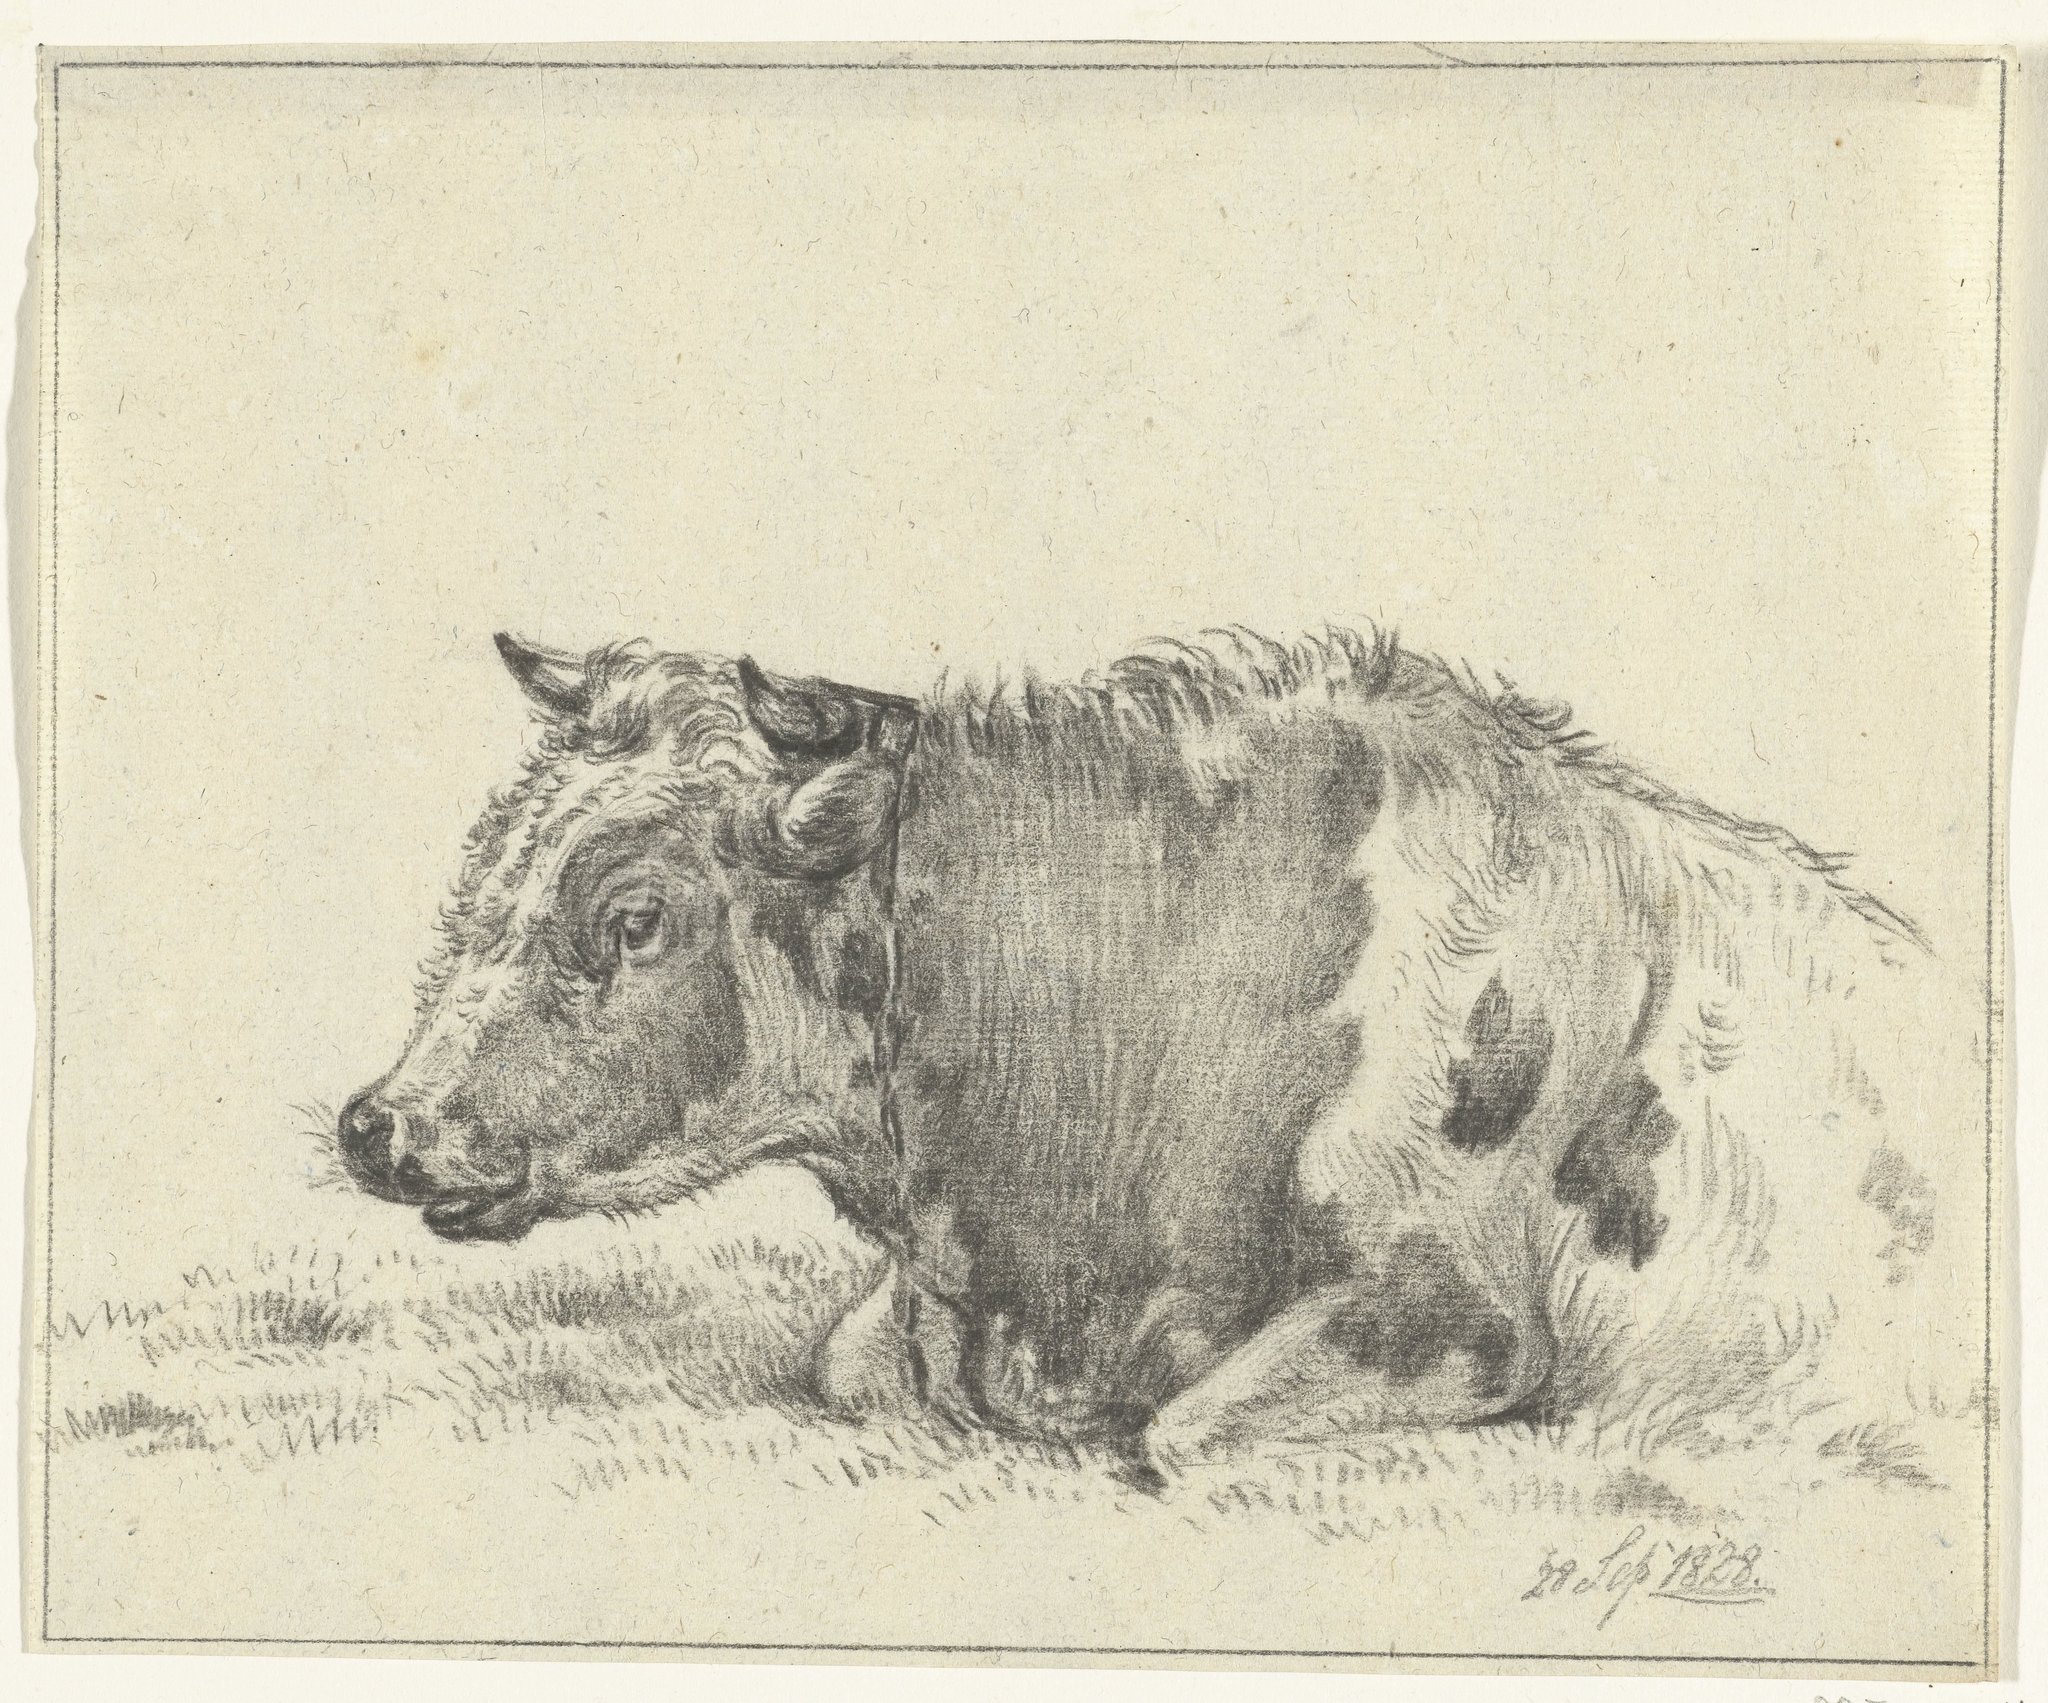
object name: drawing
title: Liggende koe, naar links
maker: jean bernard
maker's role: draughtsman, print maker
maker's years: 1765-1833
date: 1828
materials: chalk, paper, pencil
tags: cow